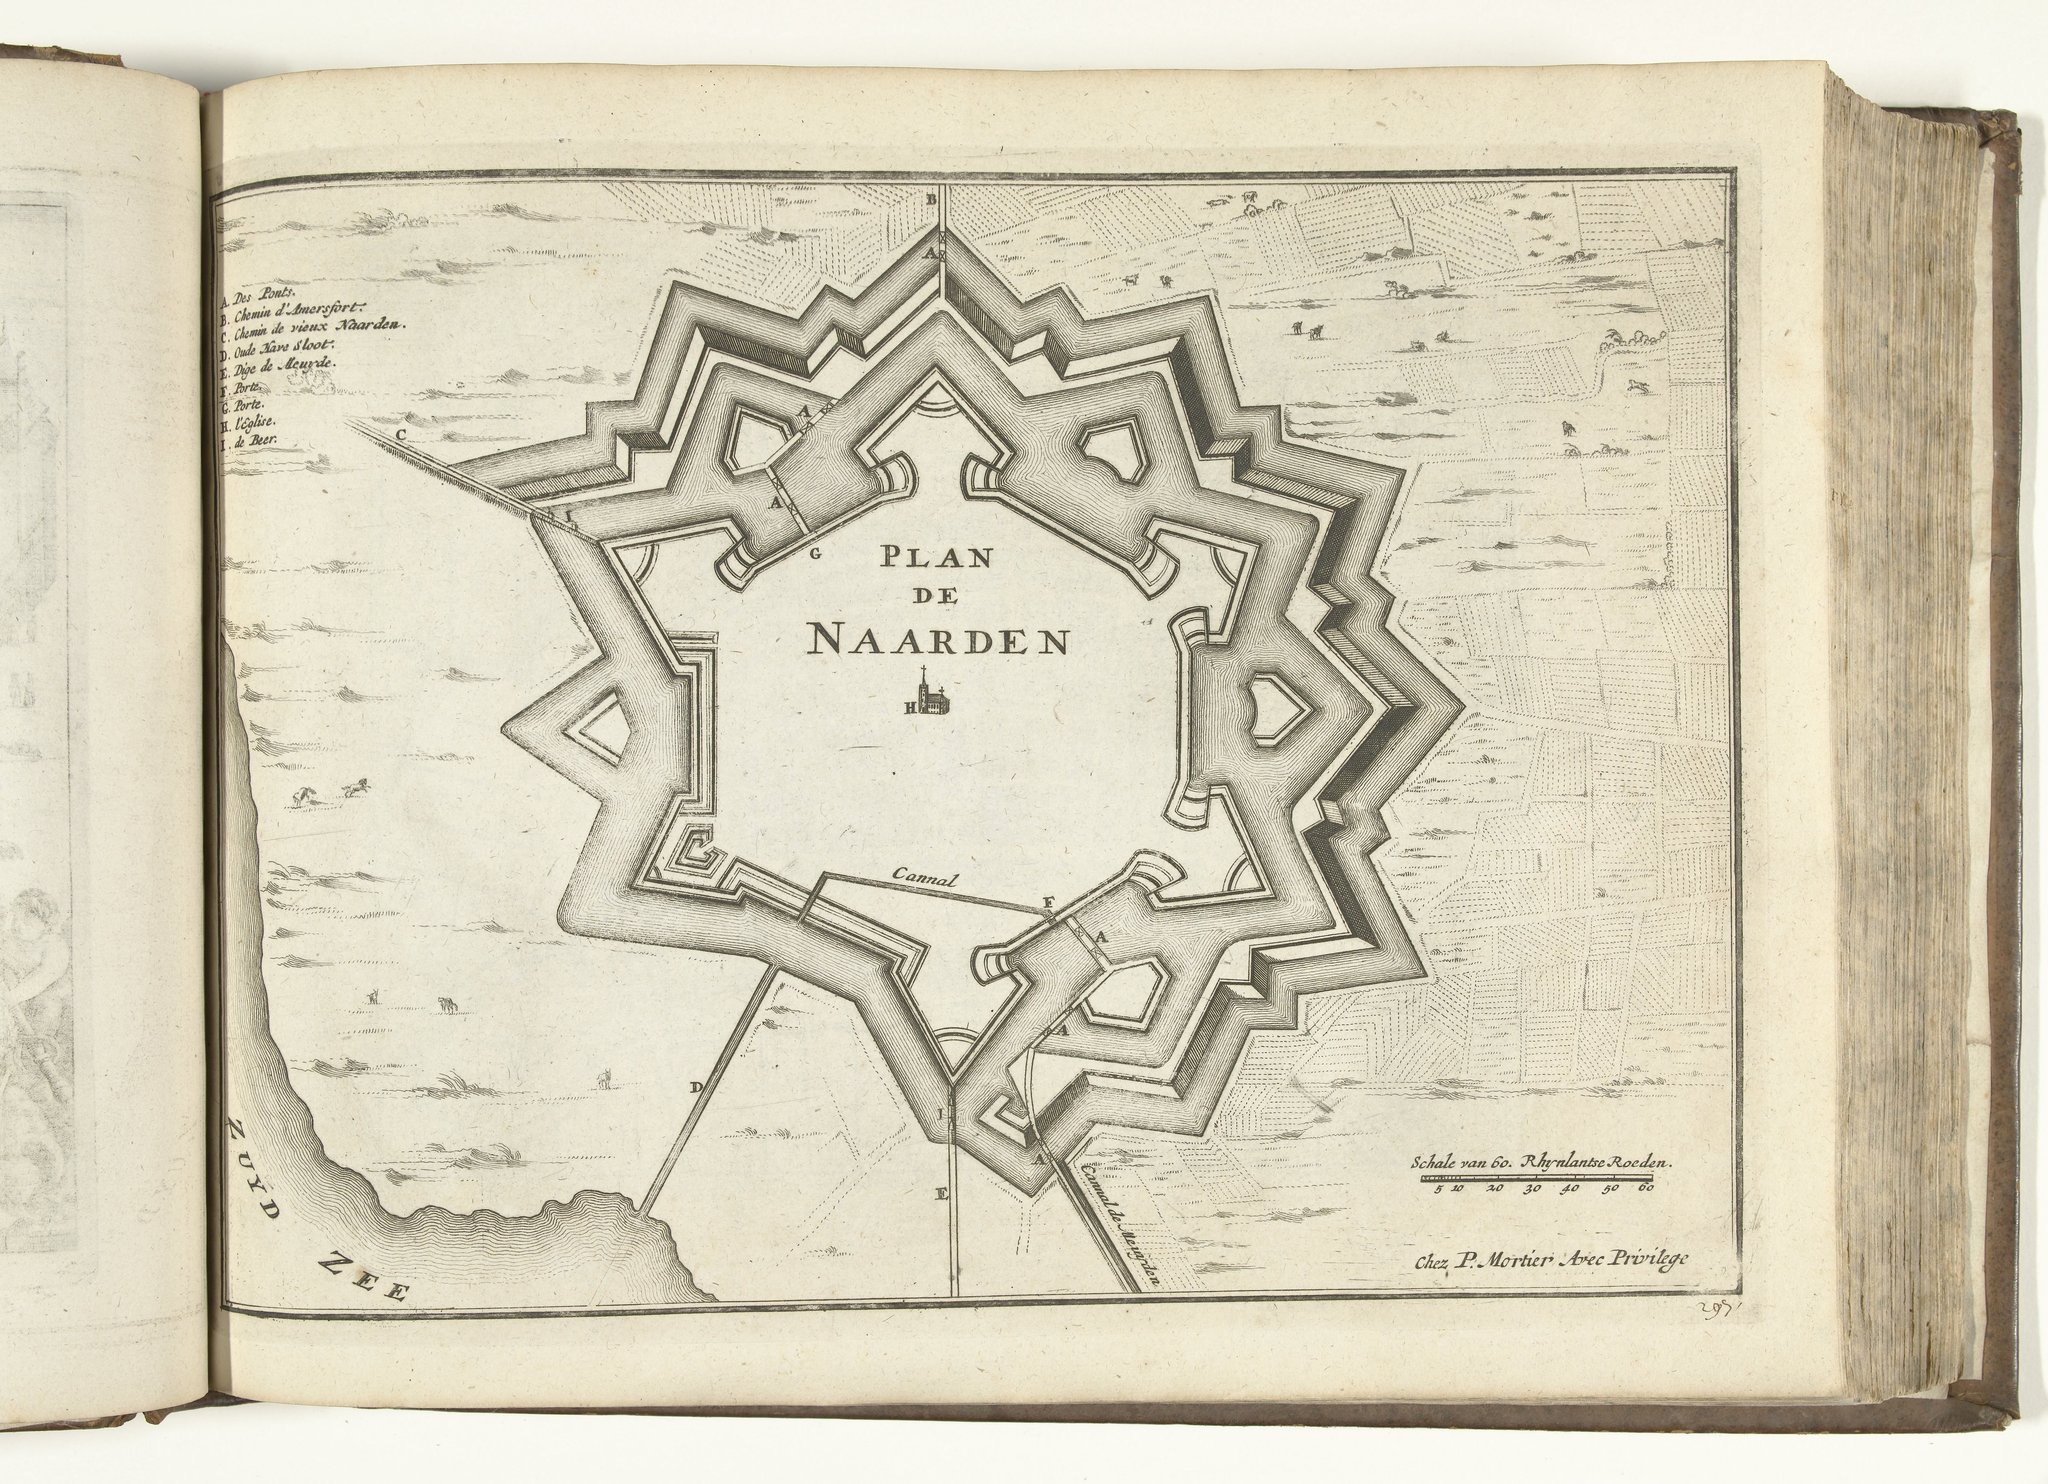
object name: map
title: Plattegrond van Naarden, 1726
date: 1726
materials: paper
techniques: etching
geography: leiden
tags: fortress, maps of cities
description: Plattegrond van de verdedigingswerken om de stad Naarden. Plaat nr. 297 in deel XIII van het prentwerk: Les Forces de l'Europe, Asie, Afrique et Amerique ... Comme aussi les Cartes des Côtes de France et d'Espagne uit 1726, dit tweede deel met 271 met de hand genummerde platen van vermaarde sterke steden en vestingen in het kader van de Spaanse Successieoorlog 1701-1713. Voor het merendeel zijn deze platen gekopieerd naar de anonieme Franse platen van vermaarde sterke steden en vestingen: in Les forces de l'Europe en in: Le theatre de la guerre, dans les Pays-Bas, beide oorspronkelijk uitgegeven door Nicolas de Fer te Parijs (1693-1697) in het kader van de Negenjarige Oorlog. Titel en opschriften in het Frans en Nederlands.